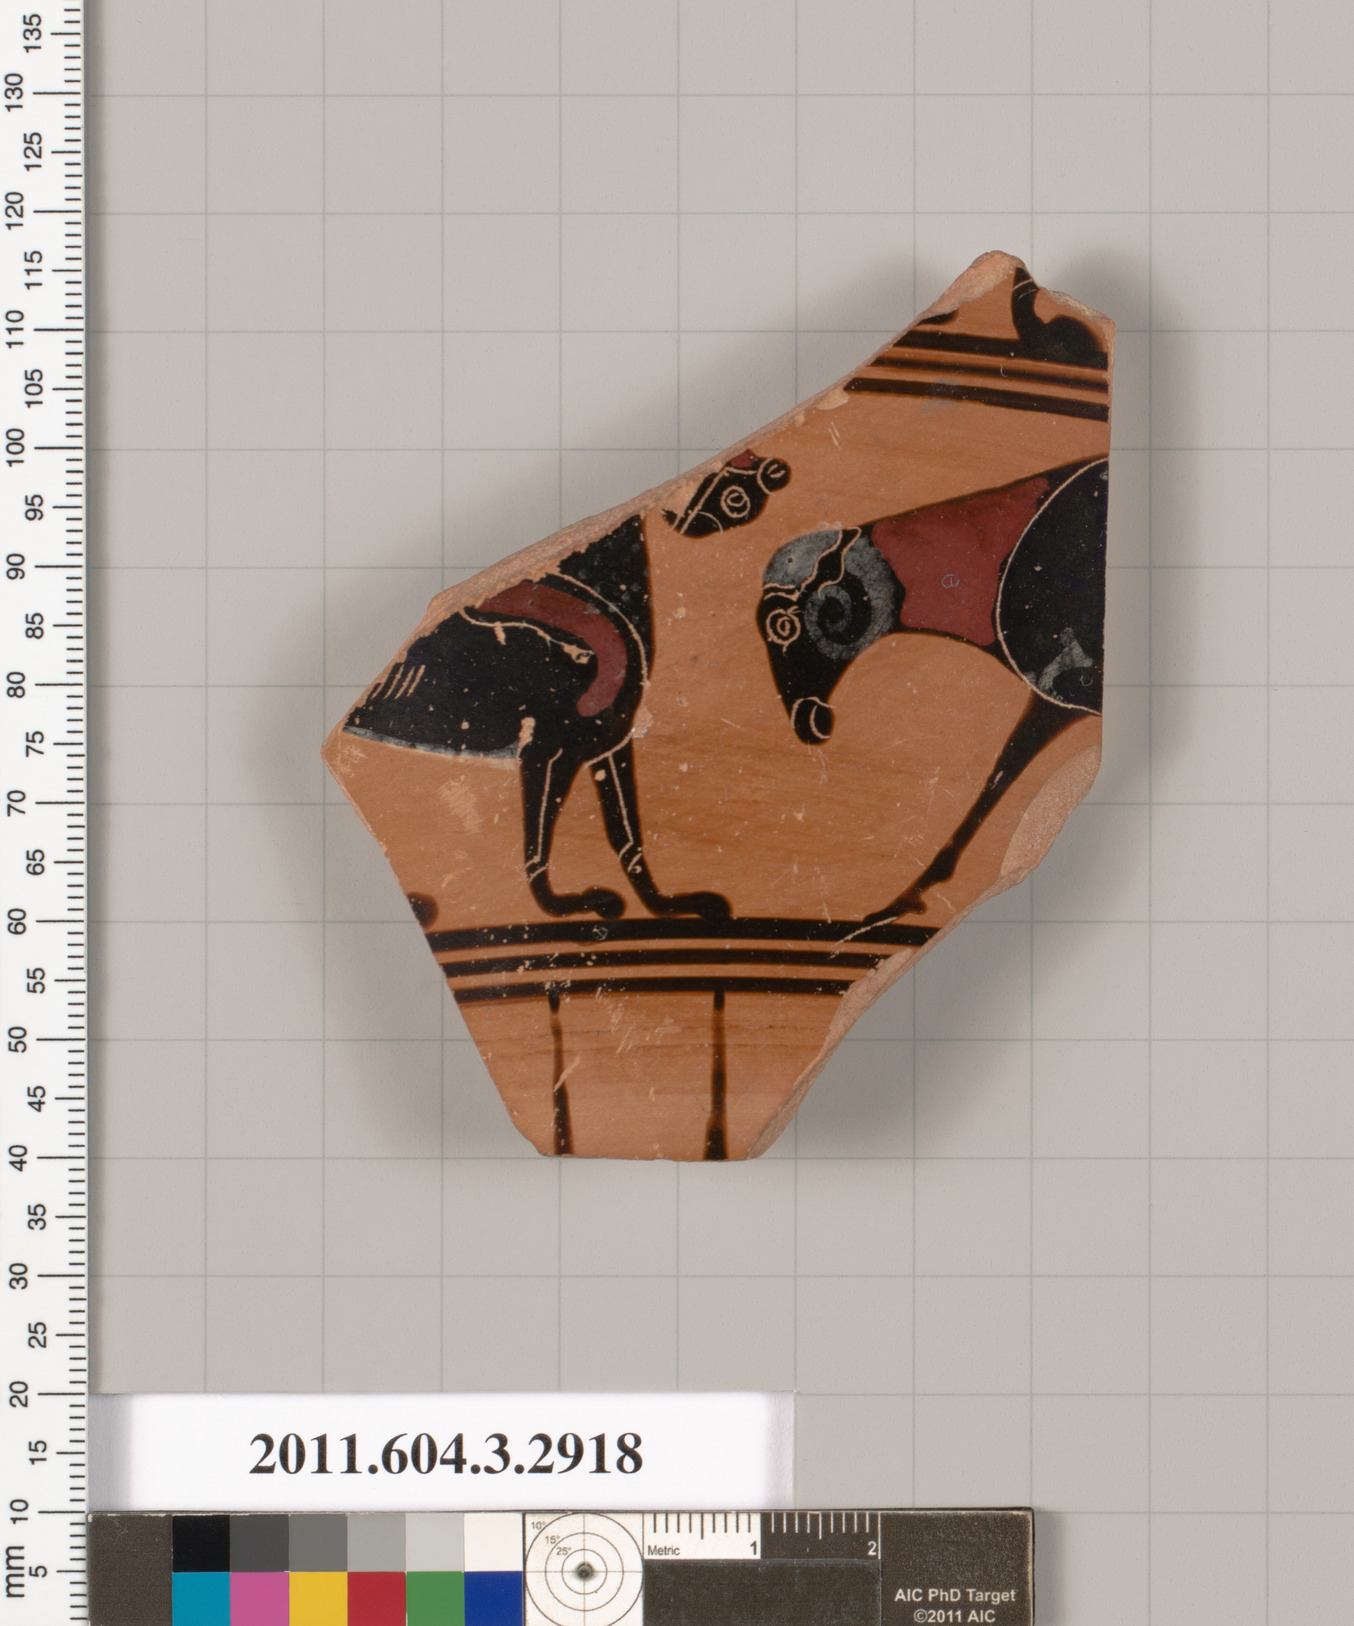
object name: neck amphora fragment, tyrrhenian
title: Terracotta fragment of a neck-amphora (jar), Tyrrhenian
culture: greek, attic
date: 575-551 BCE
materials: terracotta